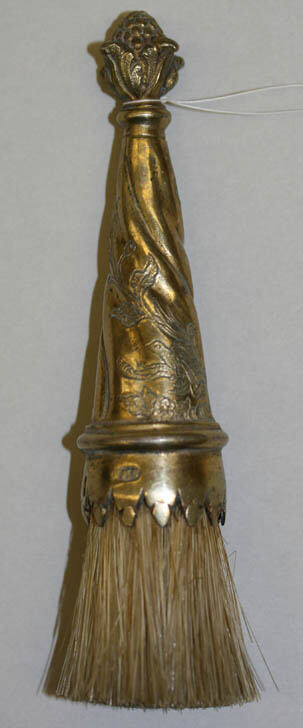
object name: brush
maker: johann martin satzger i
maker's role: maker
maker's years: 1707-1785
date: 1757-1759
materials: metal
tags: birds